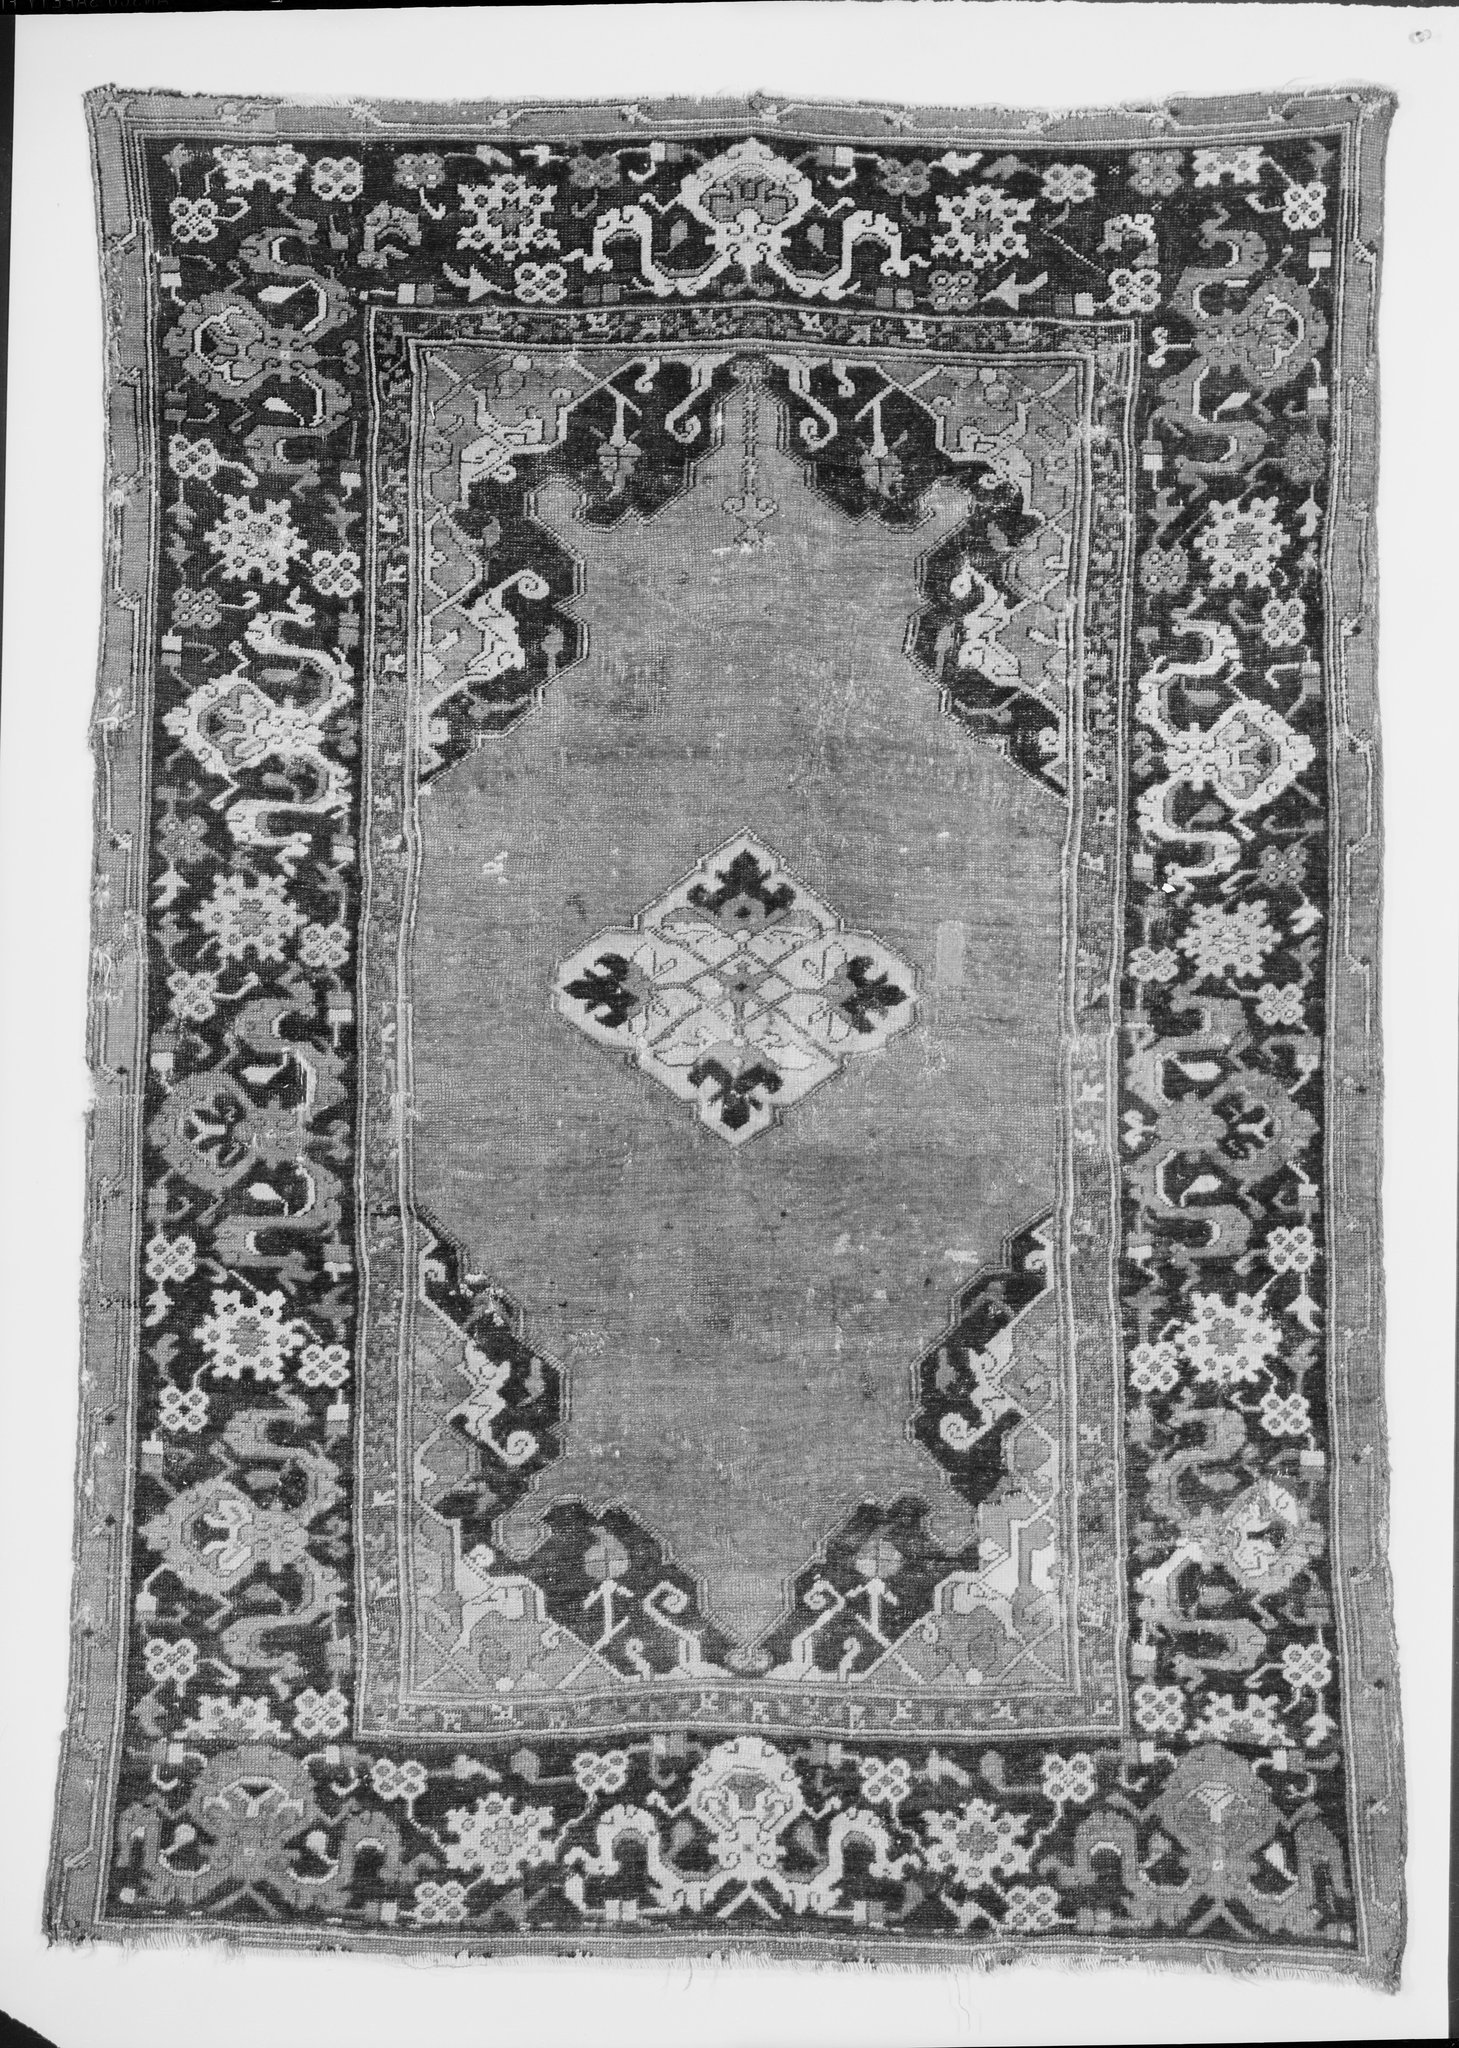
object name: carpet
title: Ushtak Type Carpet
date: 1600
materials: wool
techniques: pile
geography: turkey